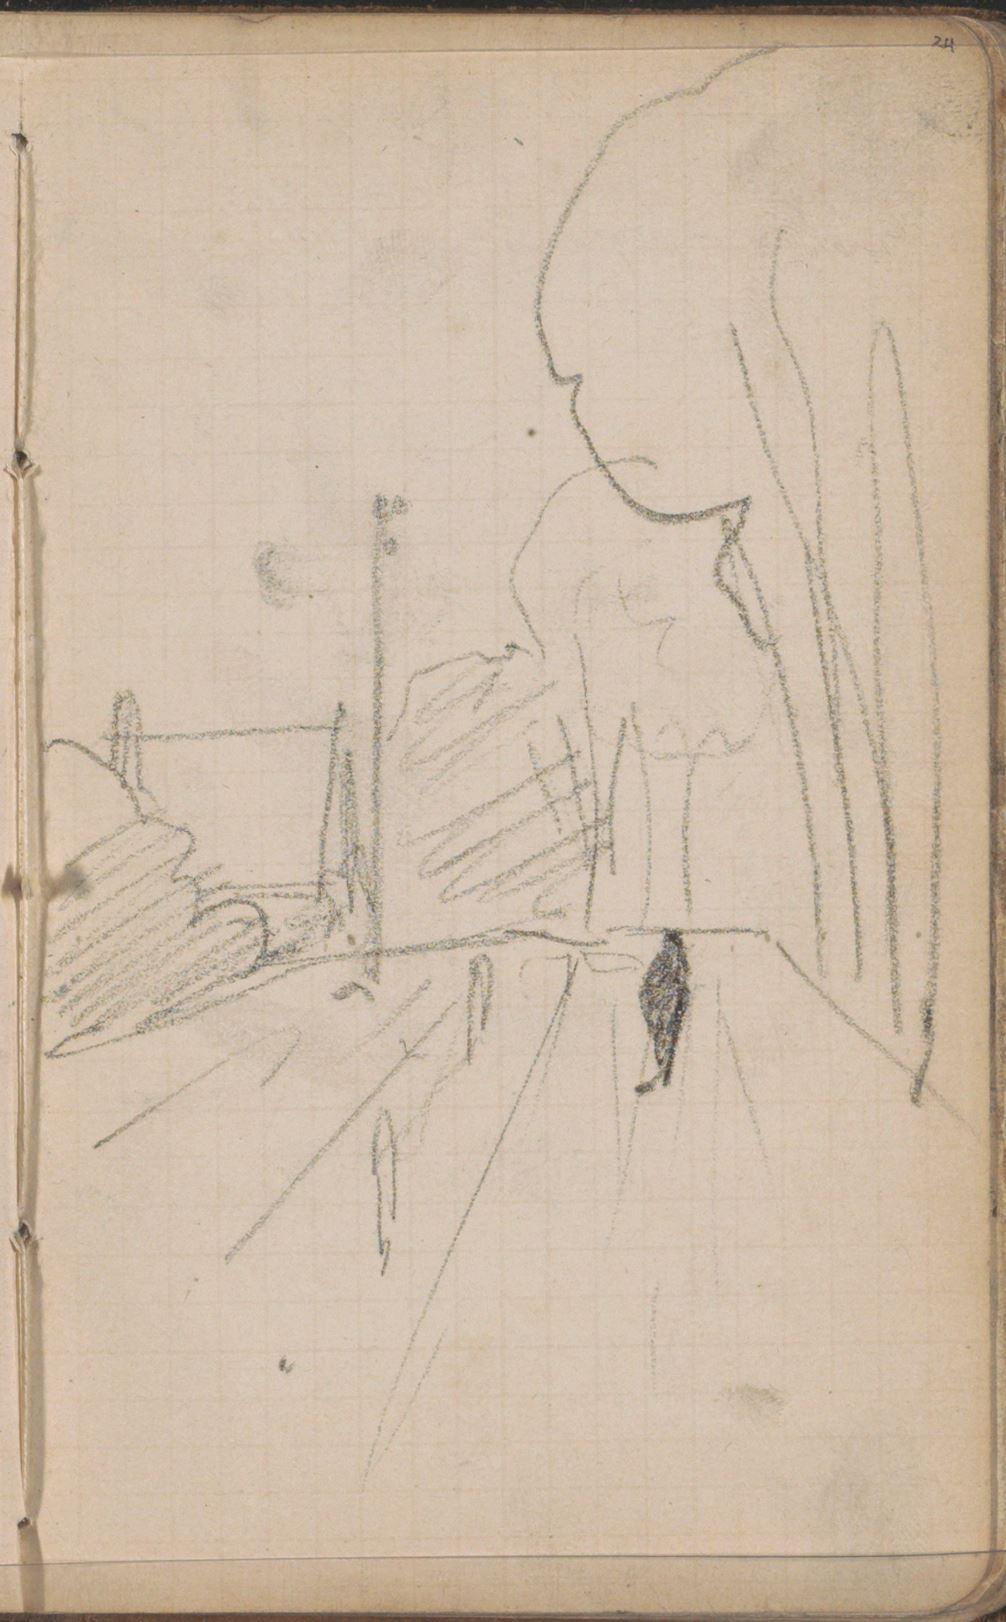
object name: sketchbook leaf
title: Figuur op een landweg met bomen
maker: marius bauer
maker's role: draughtsman, print maker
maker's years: 1867-1932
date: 1879-1885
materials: chalk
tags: trees, housing, road, path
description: Pagina 24 uit een schetsboek met 58 bladen.